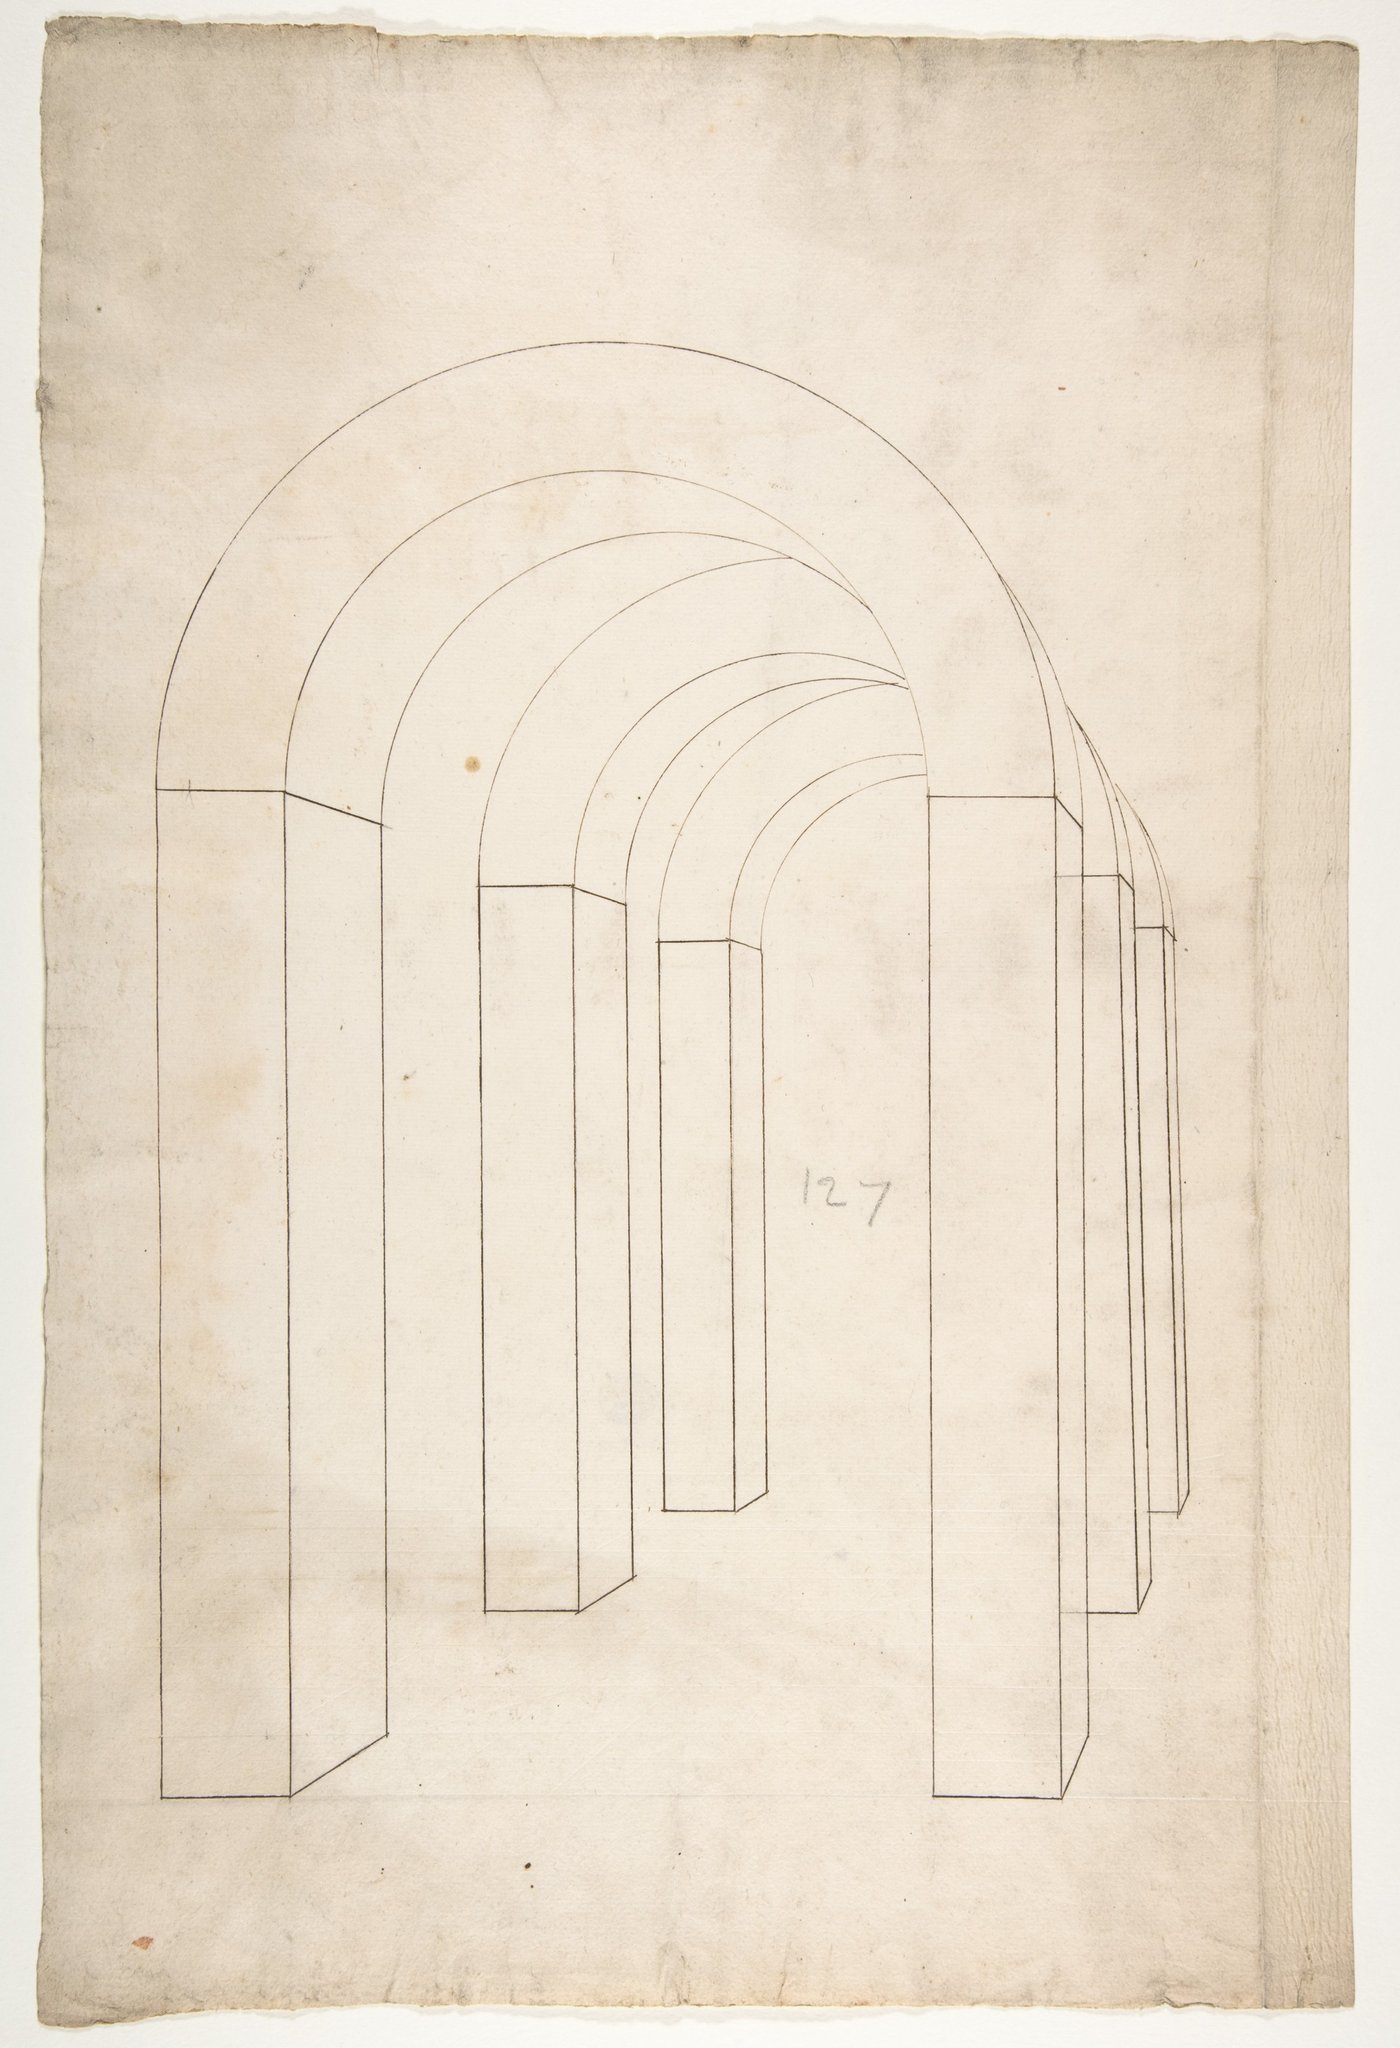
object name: drawing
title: Perspective study of an Arched Colonnade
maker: anonymous, french, 16th century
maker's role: artist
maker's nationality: french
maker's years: 1500-1600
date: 1501-1600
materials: chalk, ink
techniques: brush, pen, wash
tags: arches